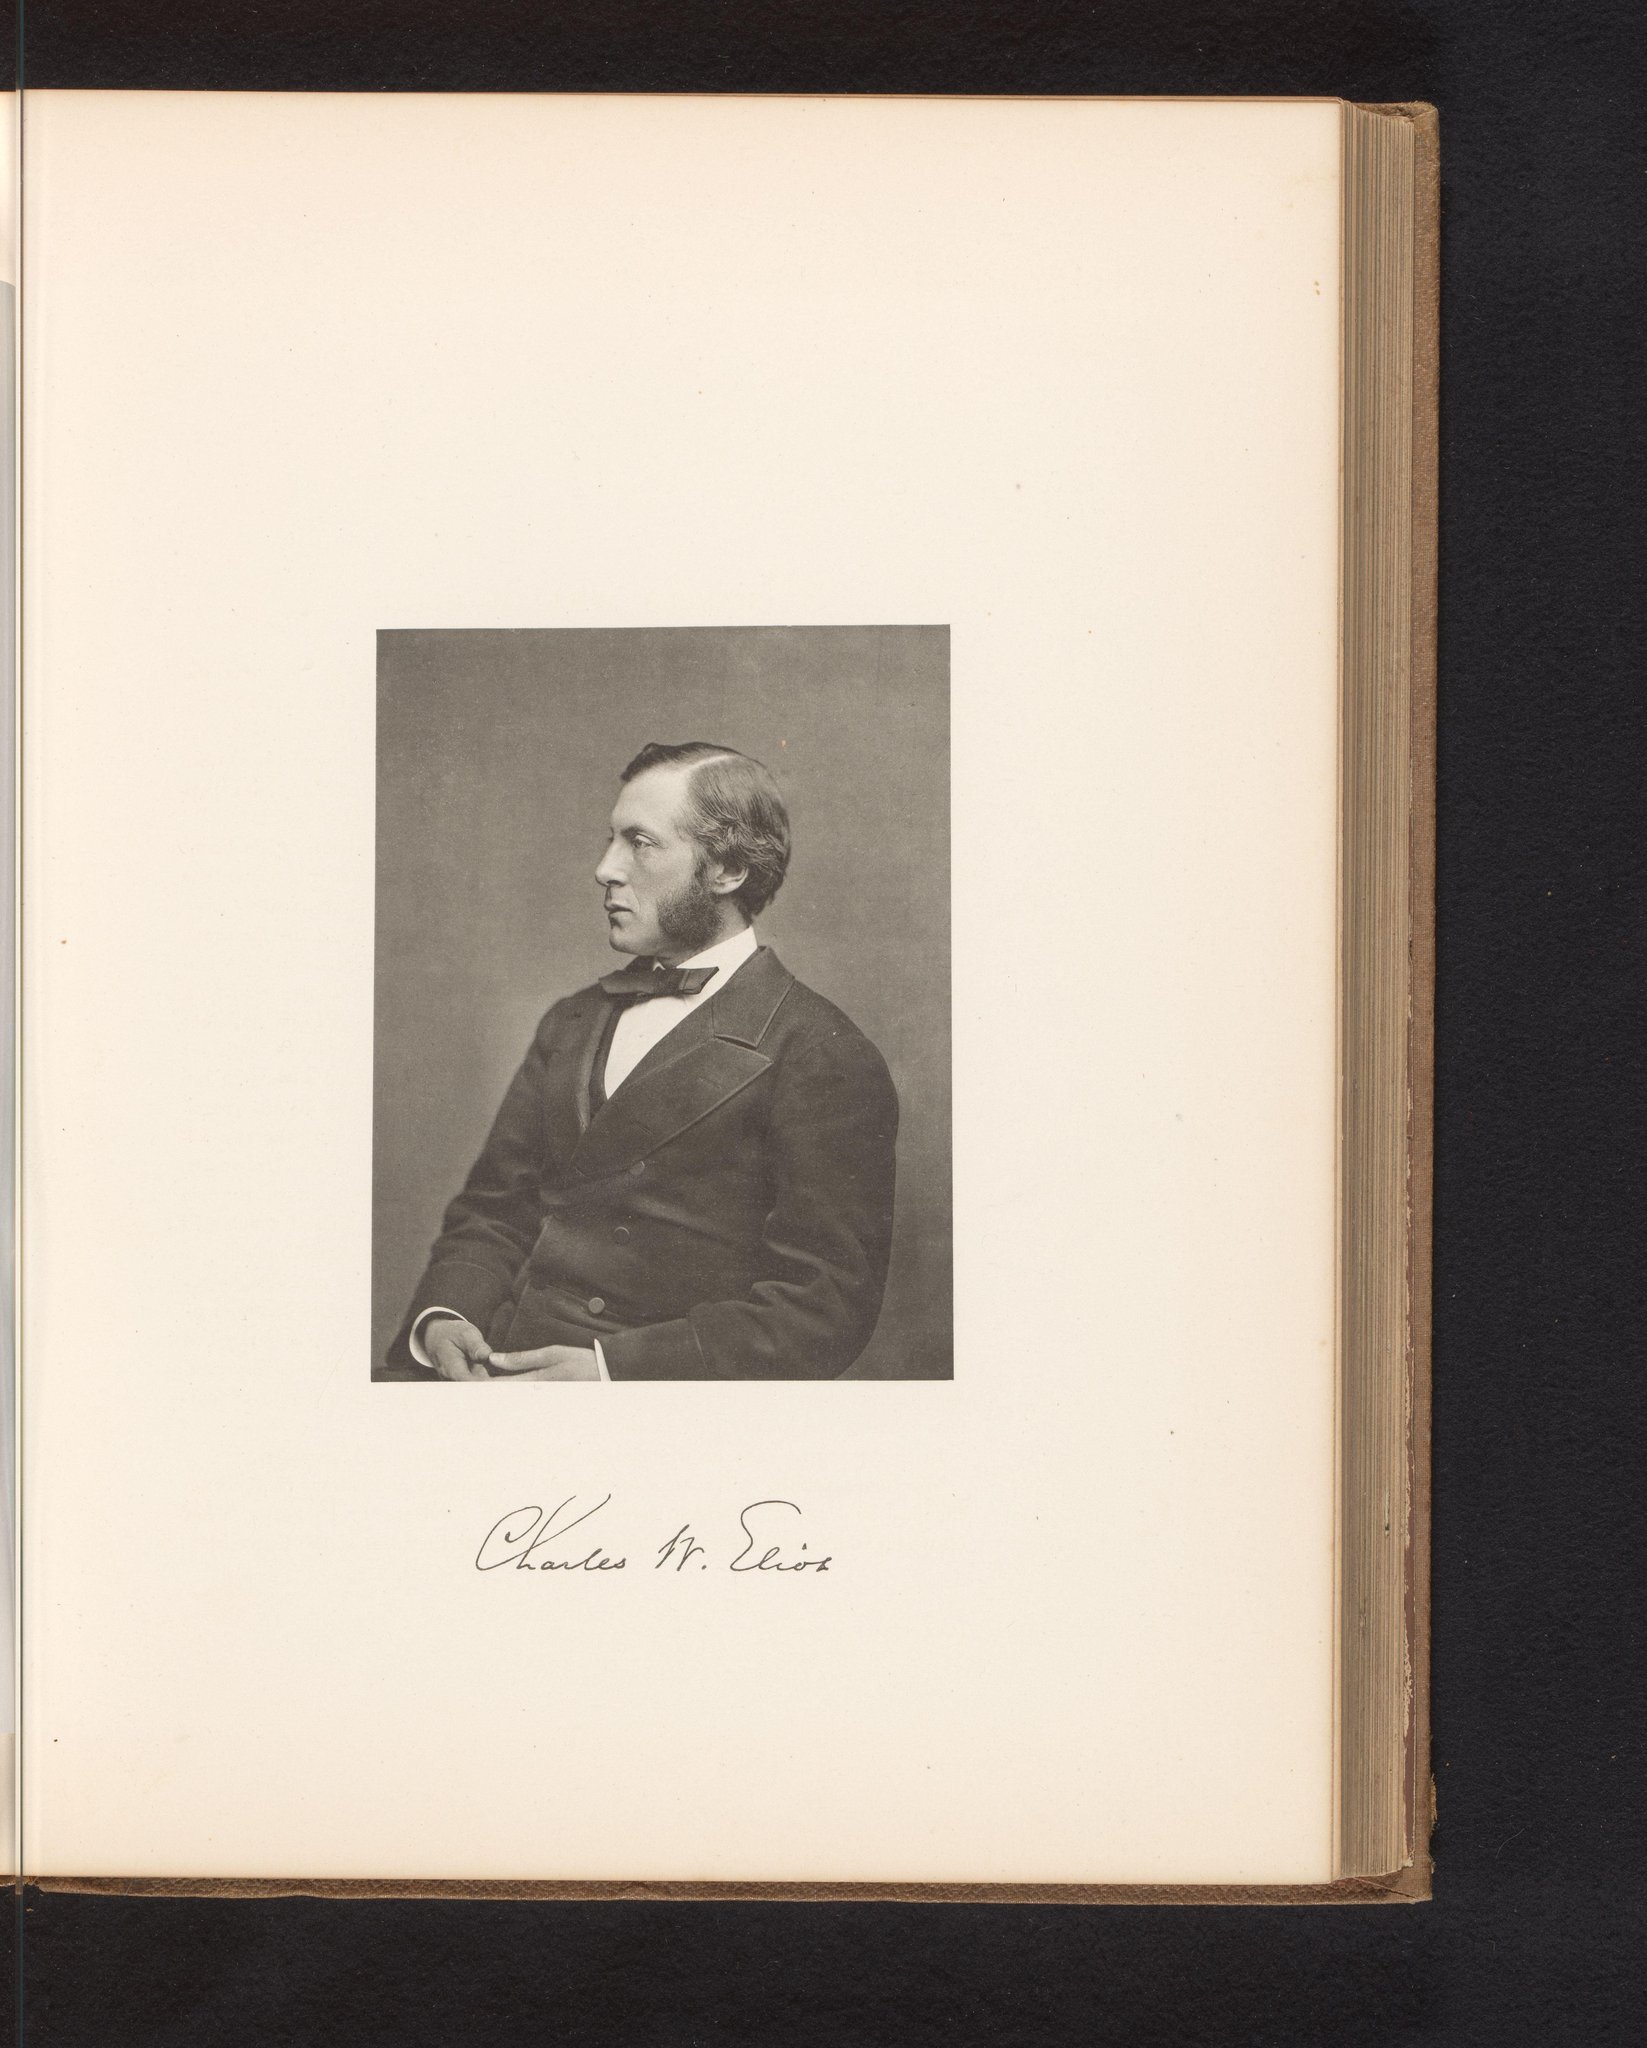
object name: photomechanical print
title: Portret van Charles William Eliot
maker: Anonymous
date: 1870-1875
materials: paper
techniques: photograph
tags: group of professors, historical persons